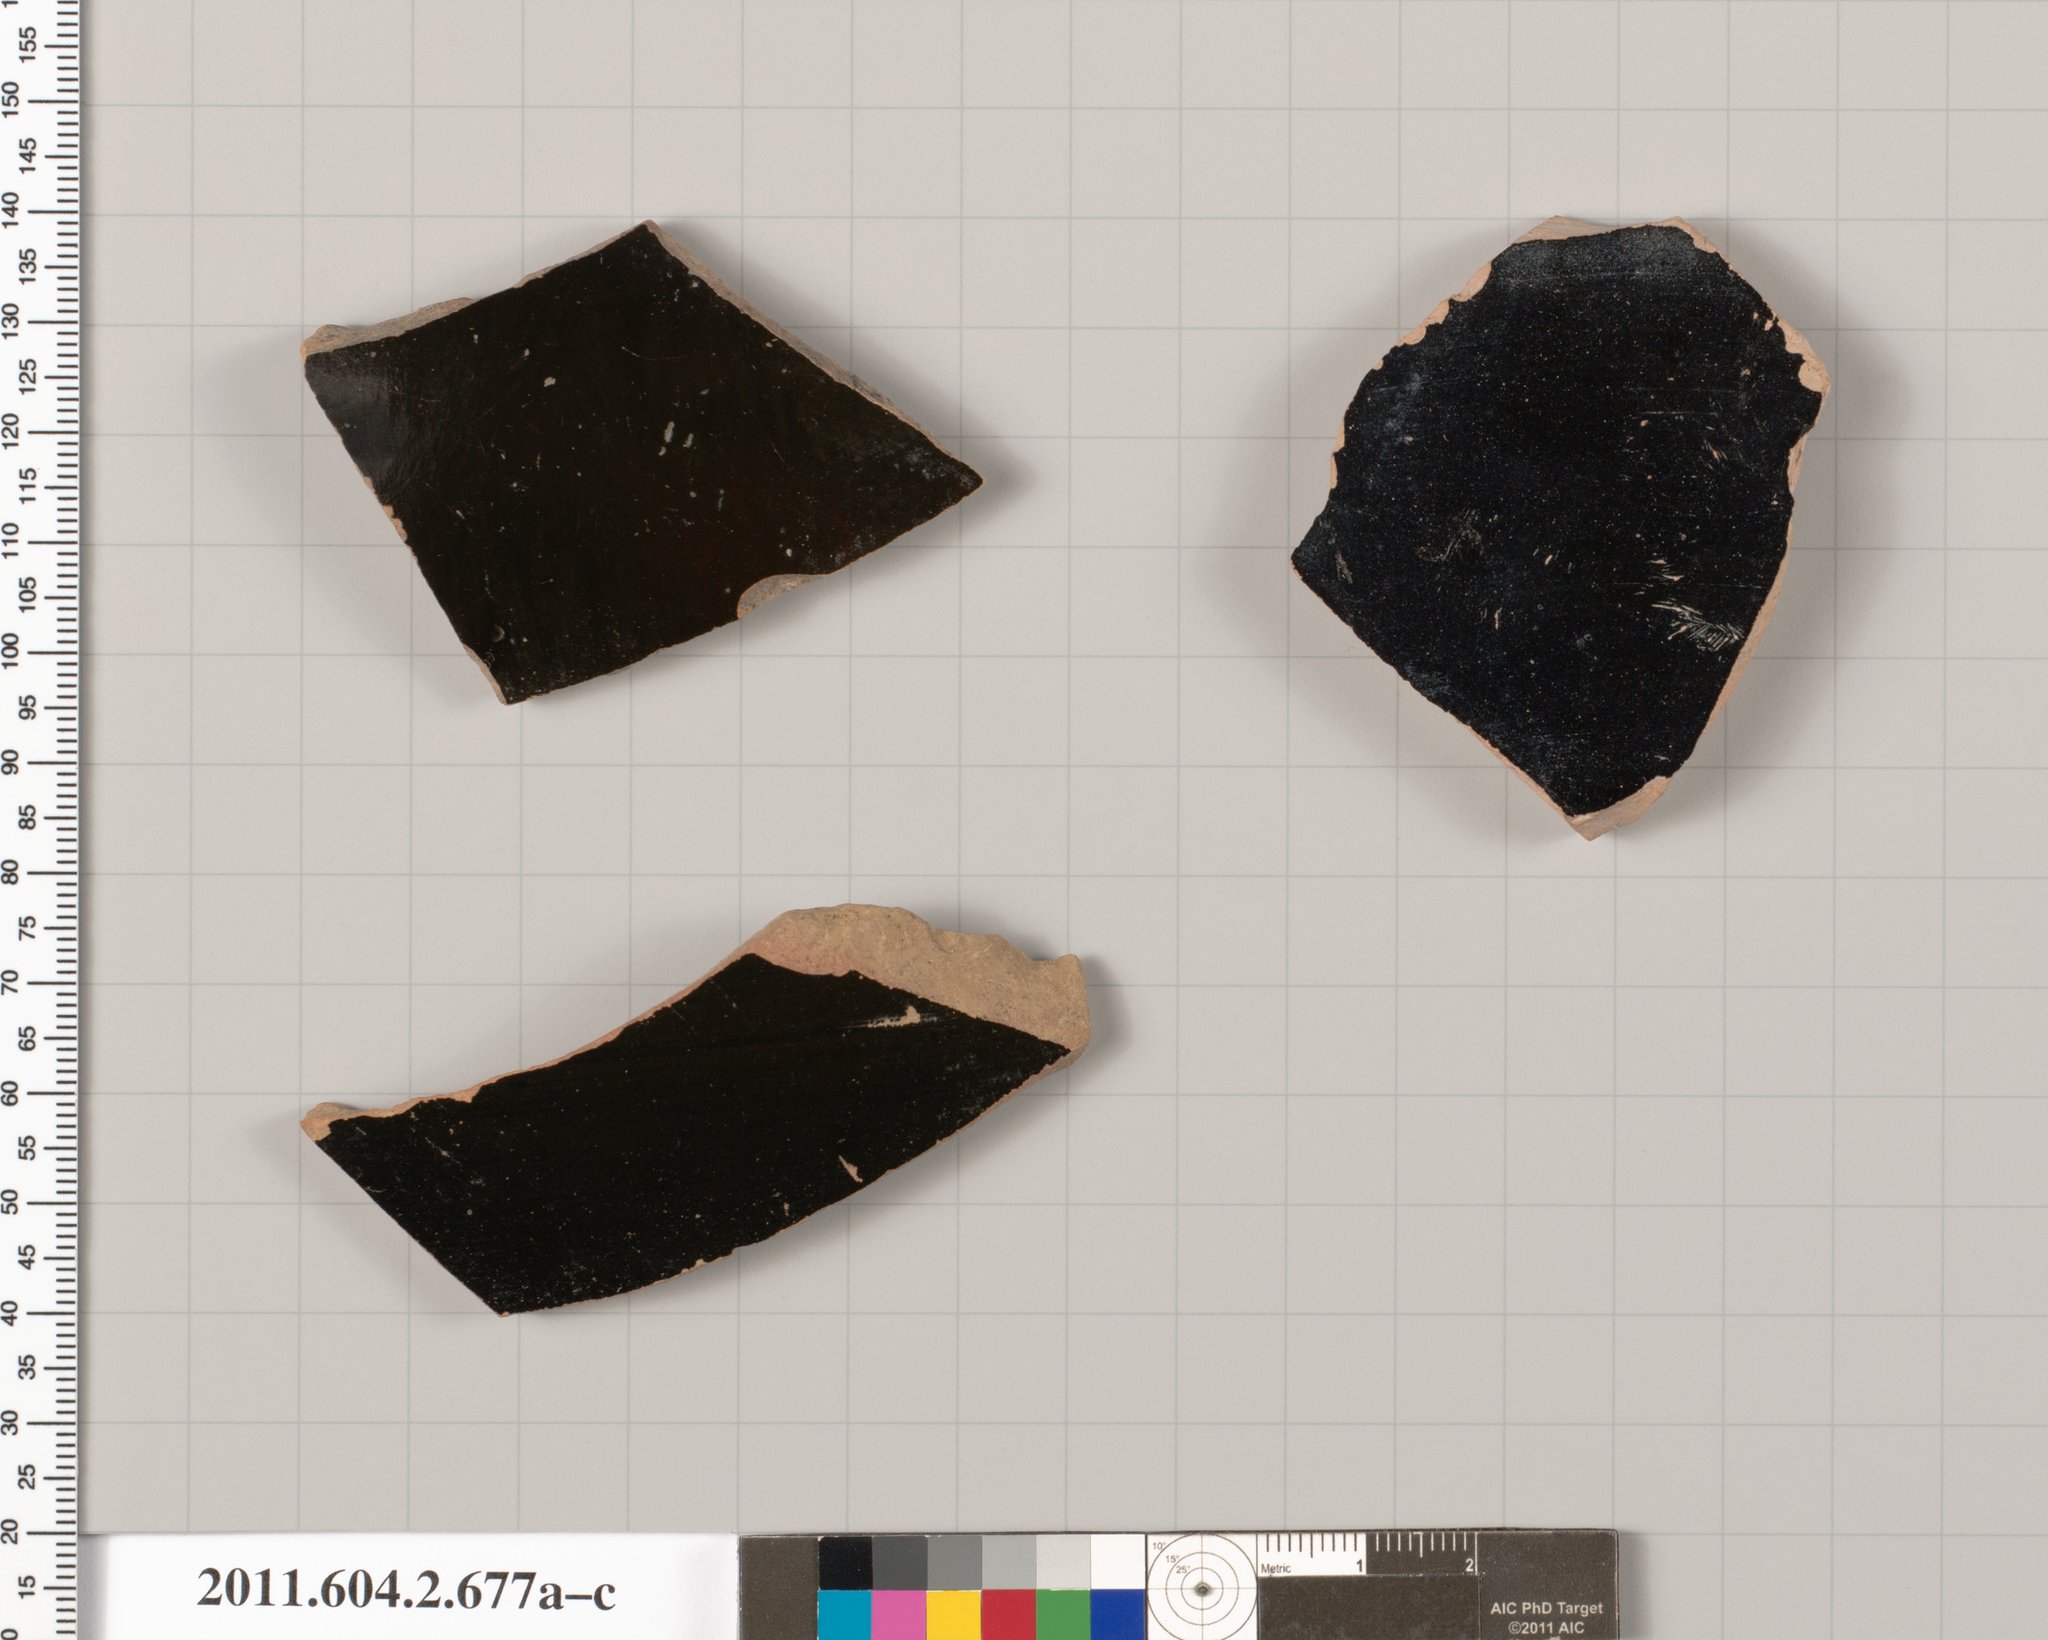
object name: column krater fragment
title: Terracotta fragments of column-kraters (bowls for mixing wine and water)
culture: greek, attic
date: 475-440 BCE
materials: terracotta